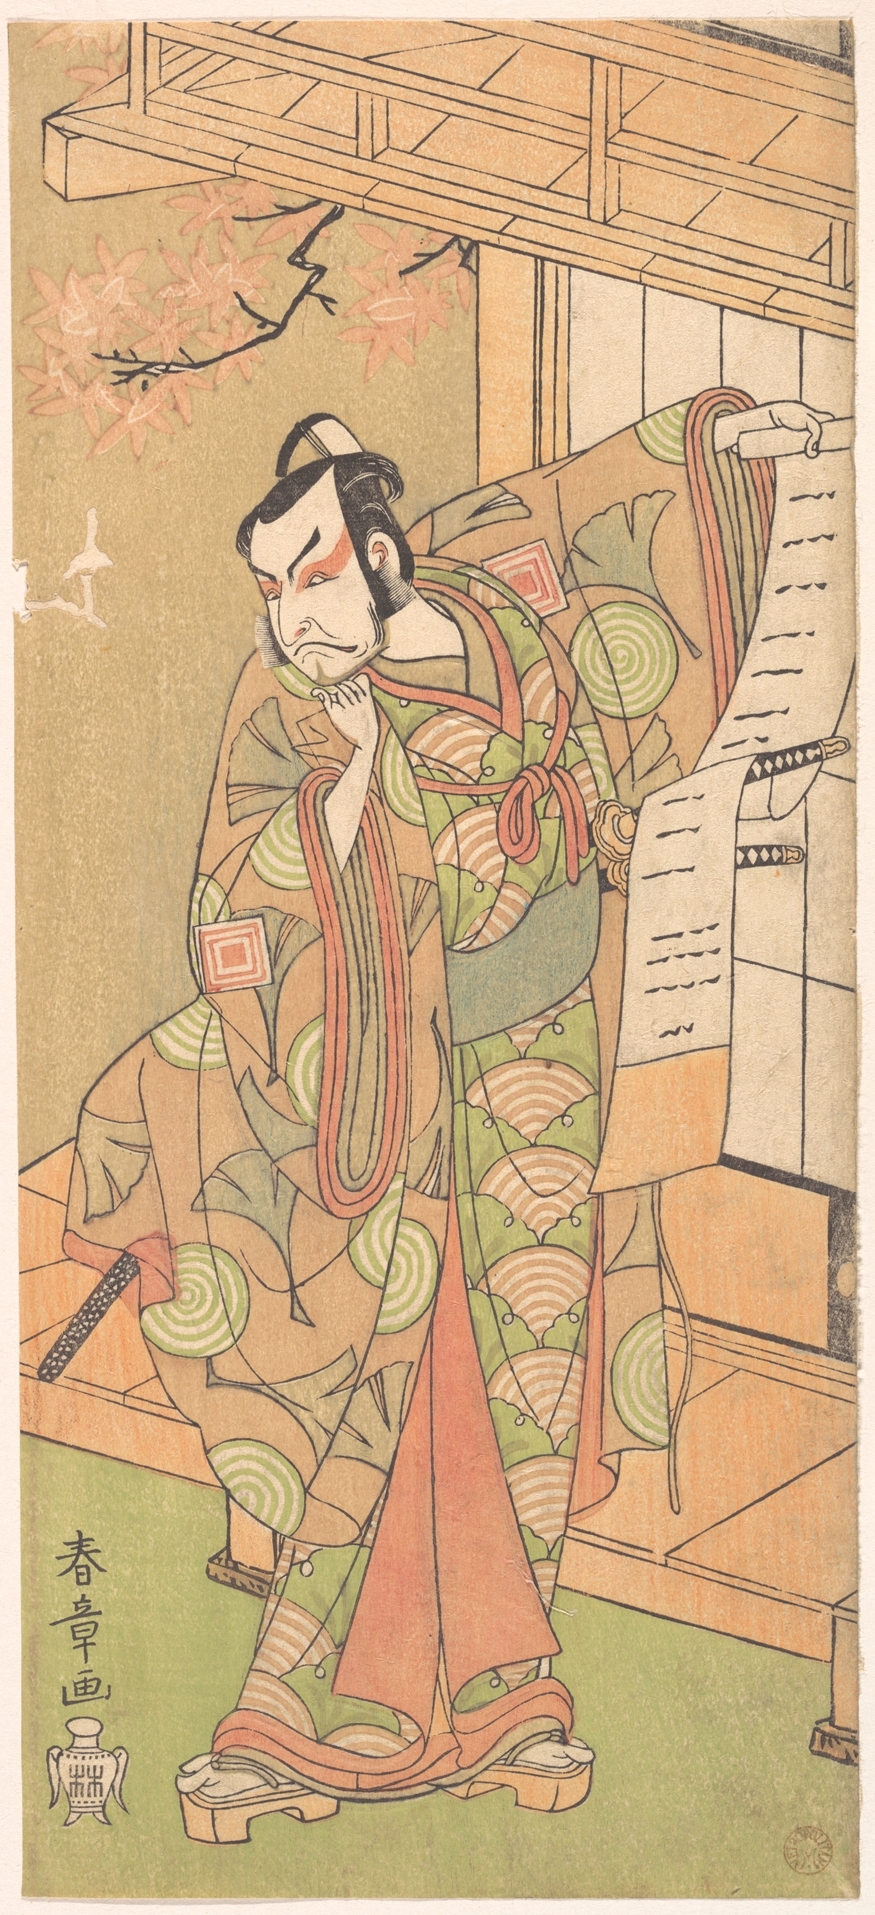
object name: woodblock print nishiki e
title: The Fourth Ichikawa Danjuro as a Samurai of High Rank Standing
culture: japanese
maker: katsukawa shunshō 勝川春章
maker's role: artist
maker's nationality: japanese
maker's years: 1726-1792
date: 1770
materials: ink, paper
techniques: nishiki e, woodblock print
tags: theatre,men,actors